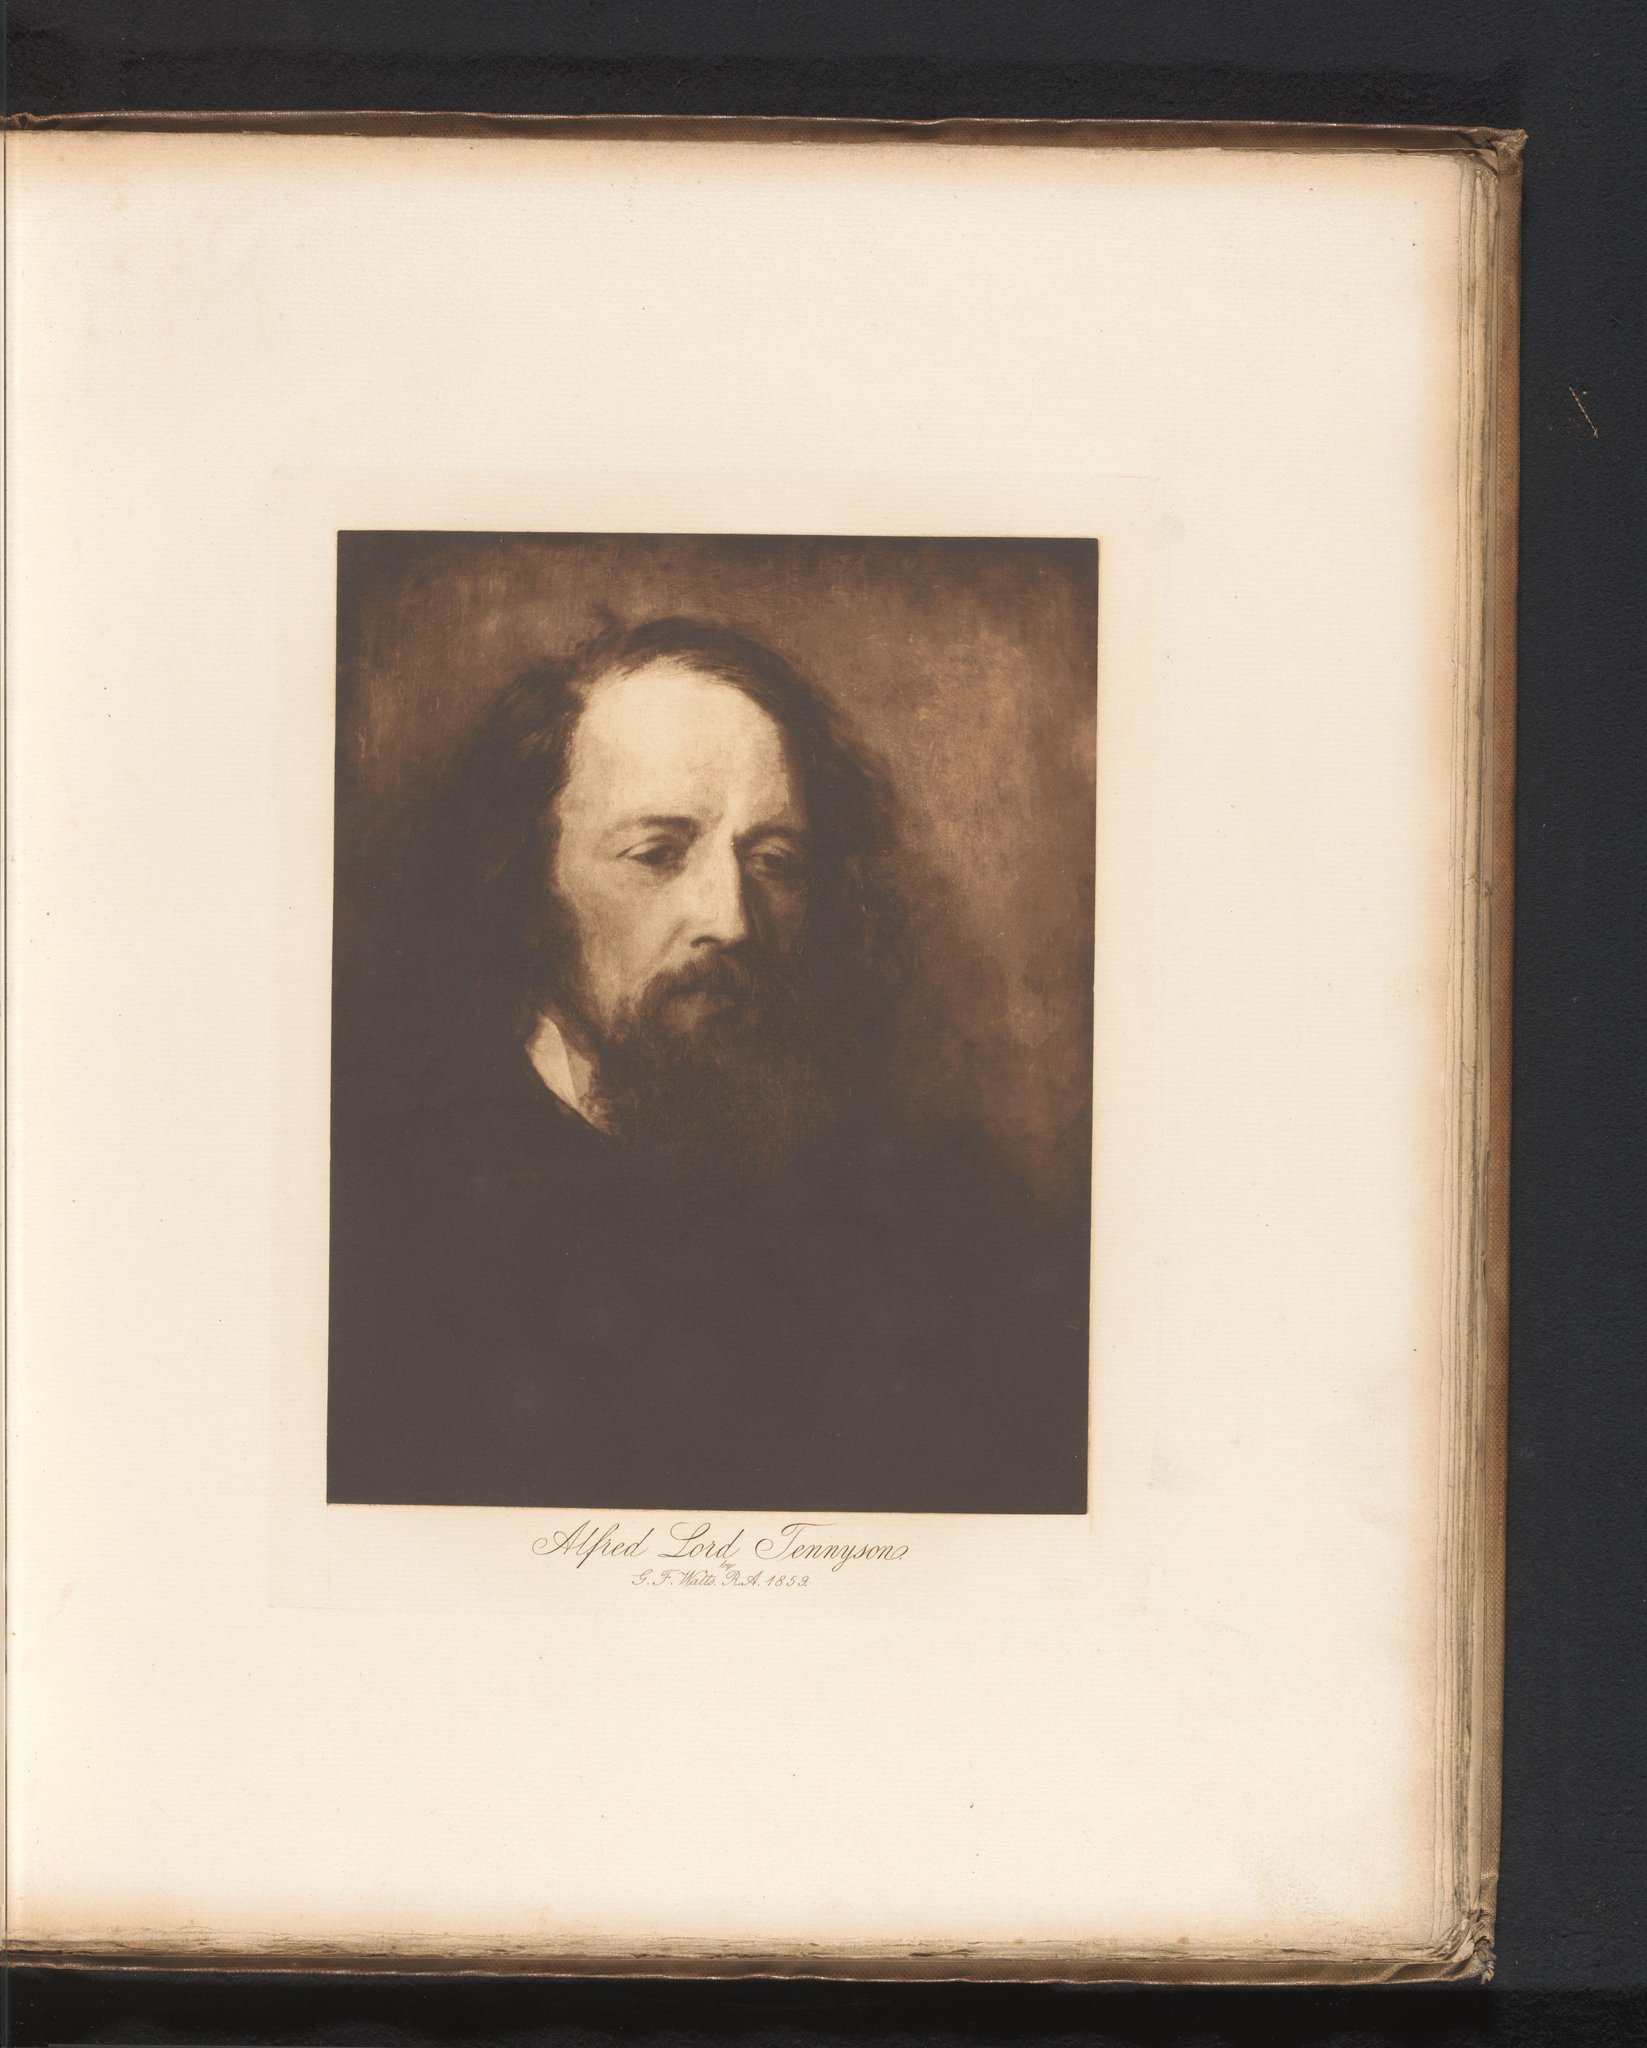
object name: page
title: Alfred Lord Tennyson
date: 1888-1893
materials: paper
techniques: photoaquatint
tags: alfred tennyson, historical persons, portrait of a writer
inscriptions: inscription: ‘Alfred Lord Tennyson/ by/ G. F. Watts. R.A. 1859.’